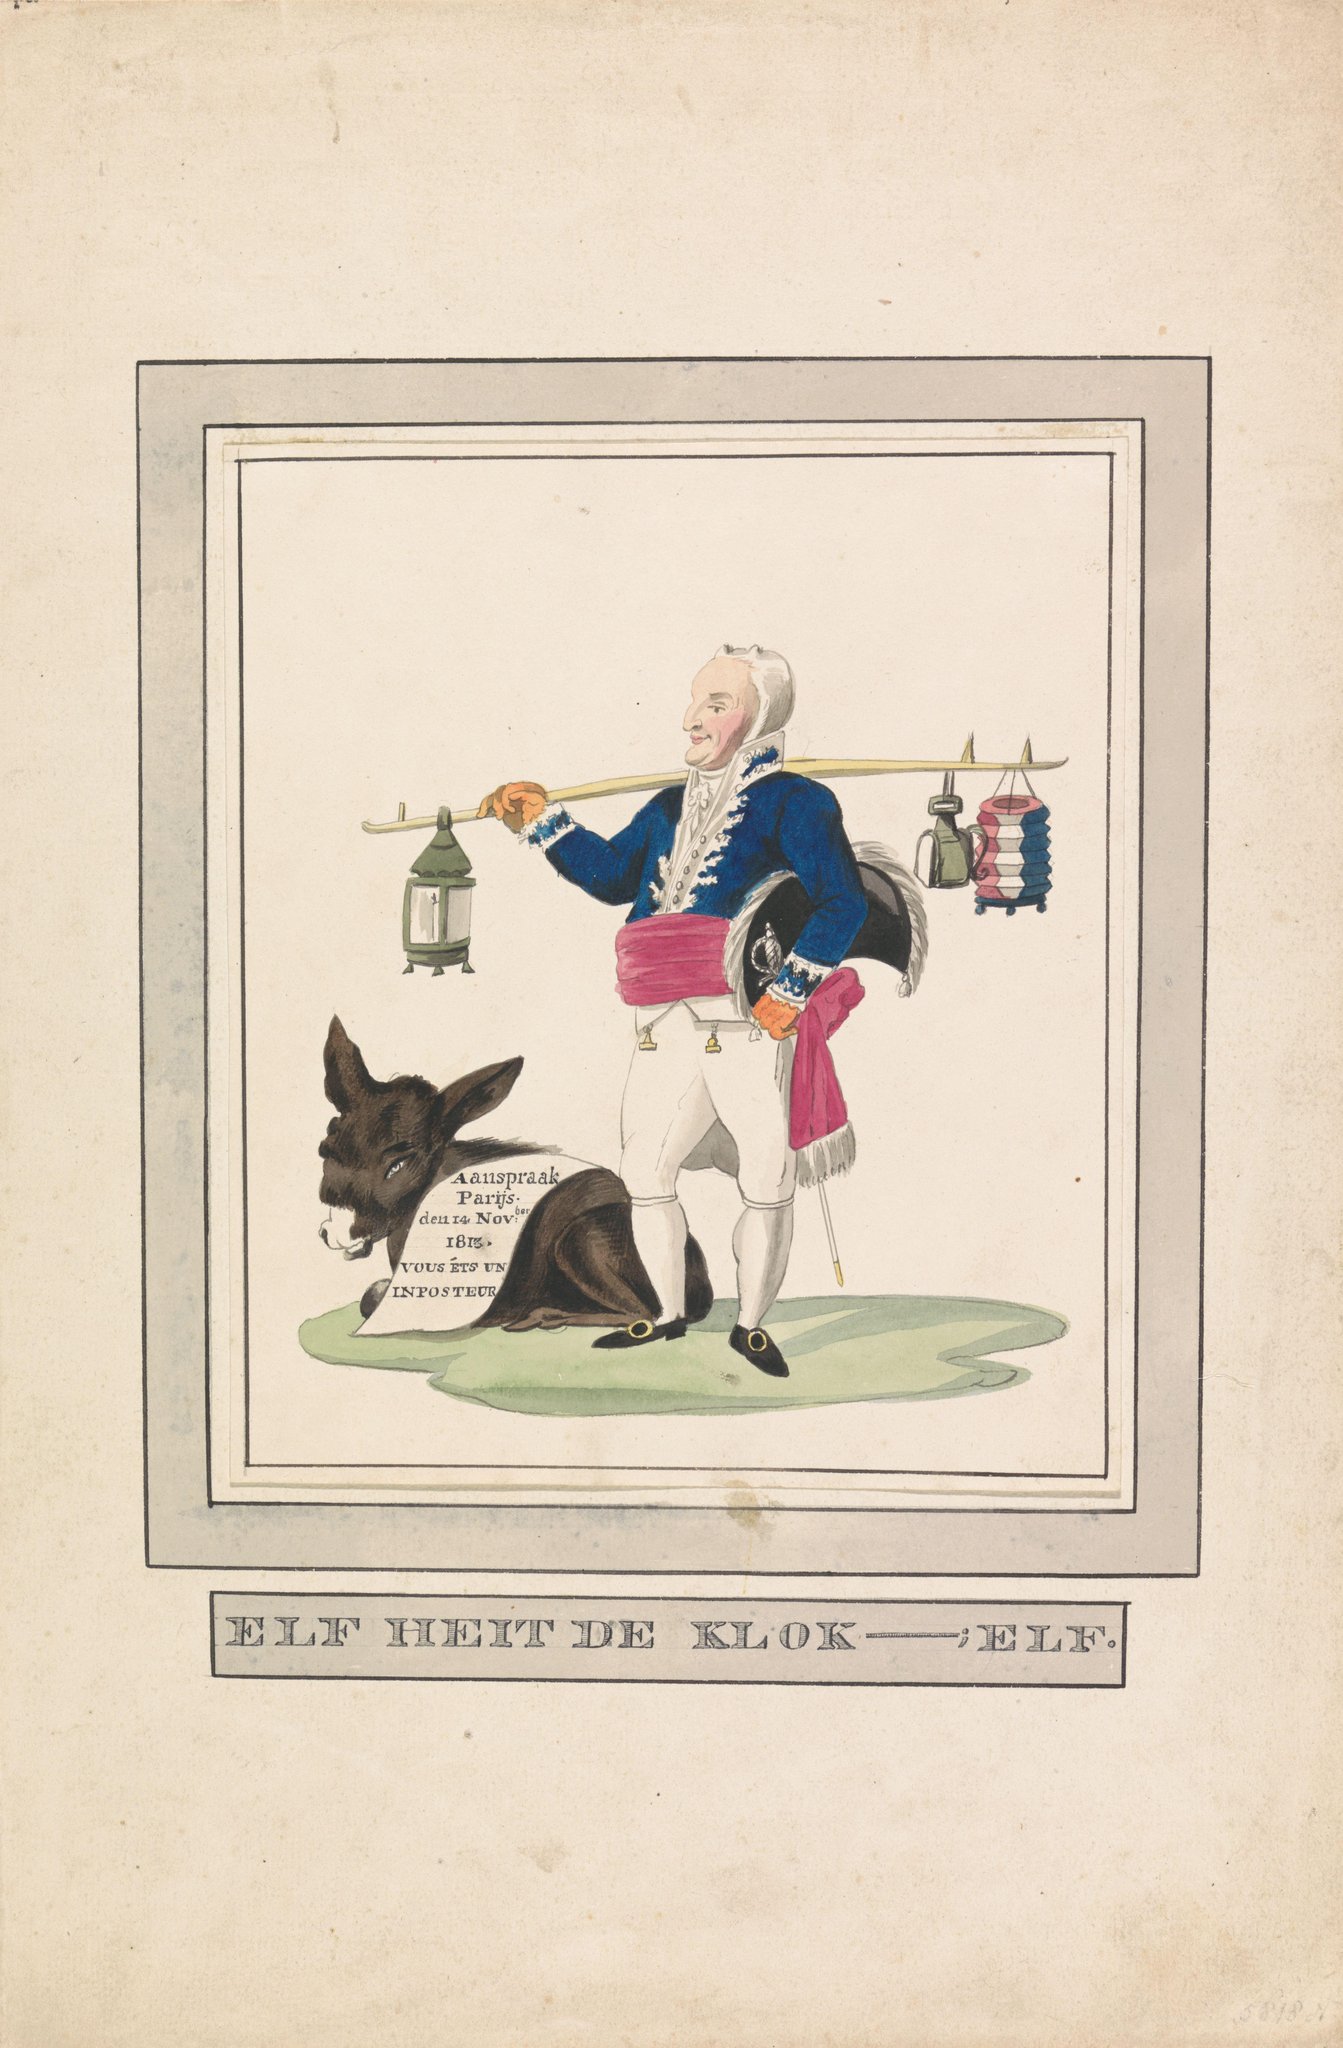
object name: cartoon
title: Spotprent op Talleyrand, 1813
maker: Anonymous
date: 1813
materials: paper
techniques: brush, pen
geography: netherlands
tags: paris, politician, charles maurice hertog van talleyrand-périgord, ass, donkey, oral advertising, lantern, 'cris de paris', cries of london, etc.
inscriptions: collector's mark: Lugt 2228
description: Spotprent waarin de Franse minister Talleyrand als een lantaarnopsteker en/of stadsomroeper is voorgesteld die de tijd - elf uur - omroept. Voor hem op de grond ligt een ezel waarop de tekst 'Aanspraak Parijs - den 14 Nov.ber 1813, vous éts un inposteur'.